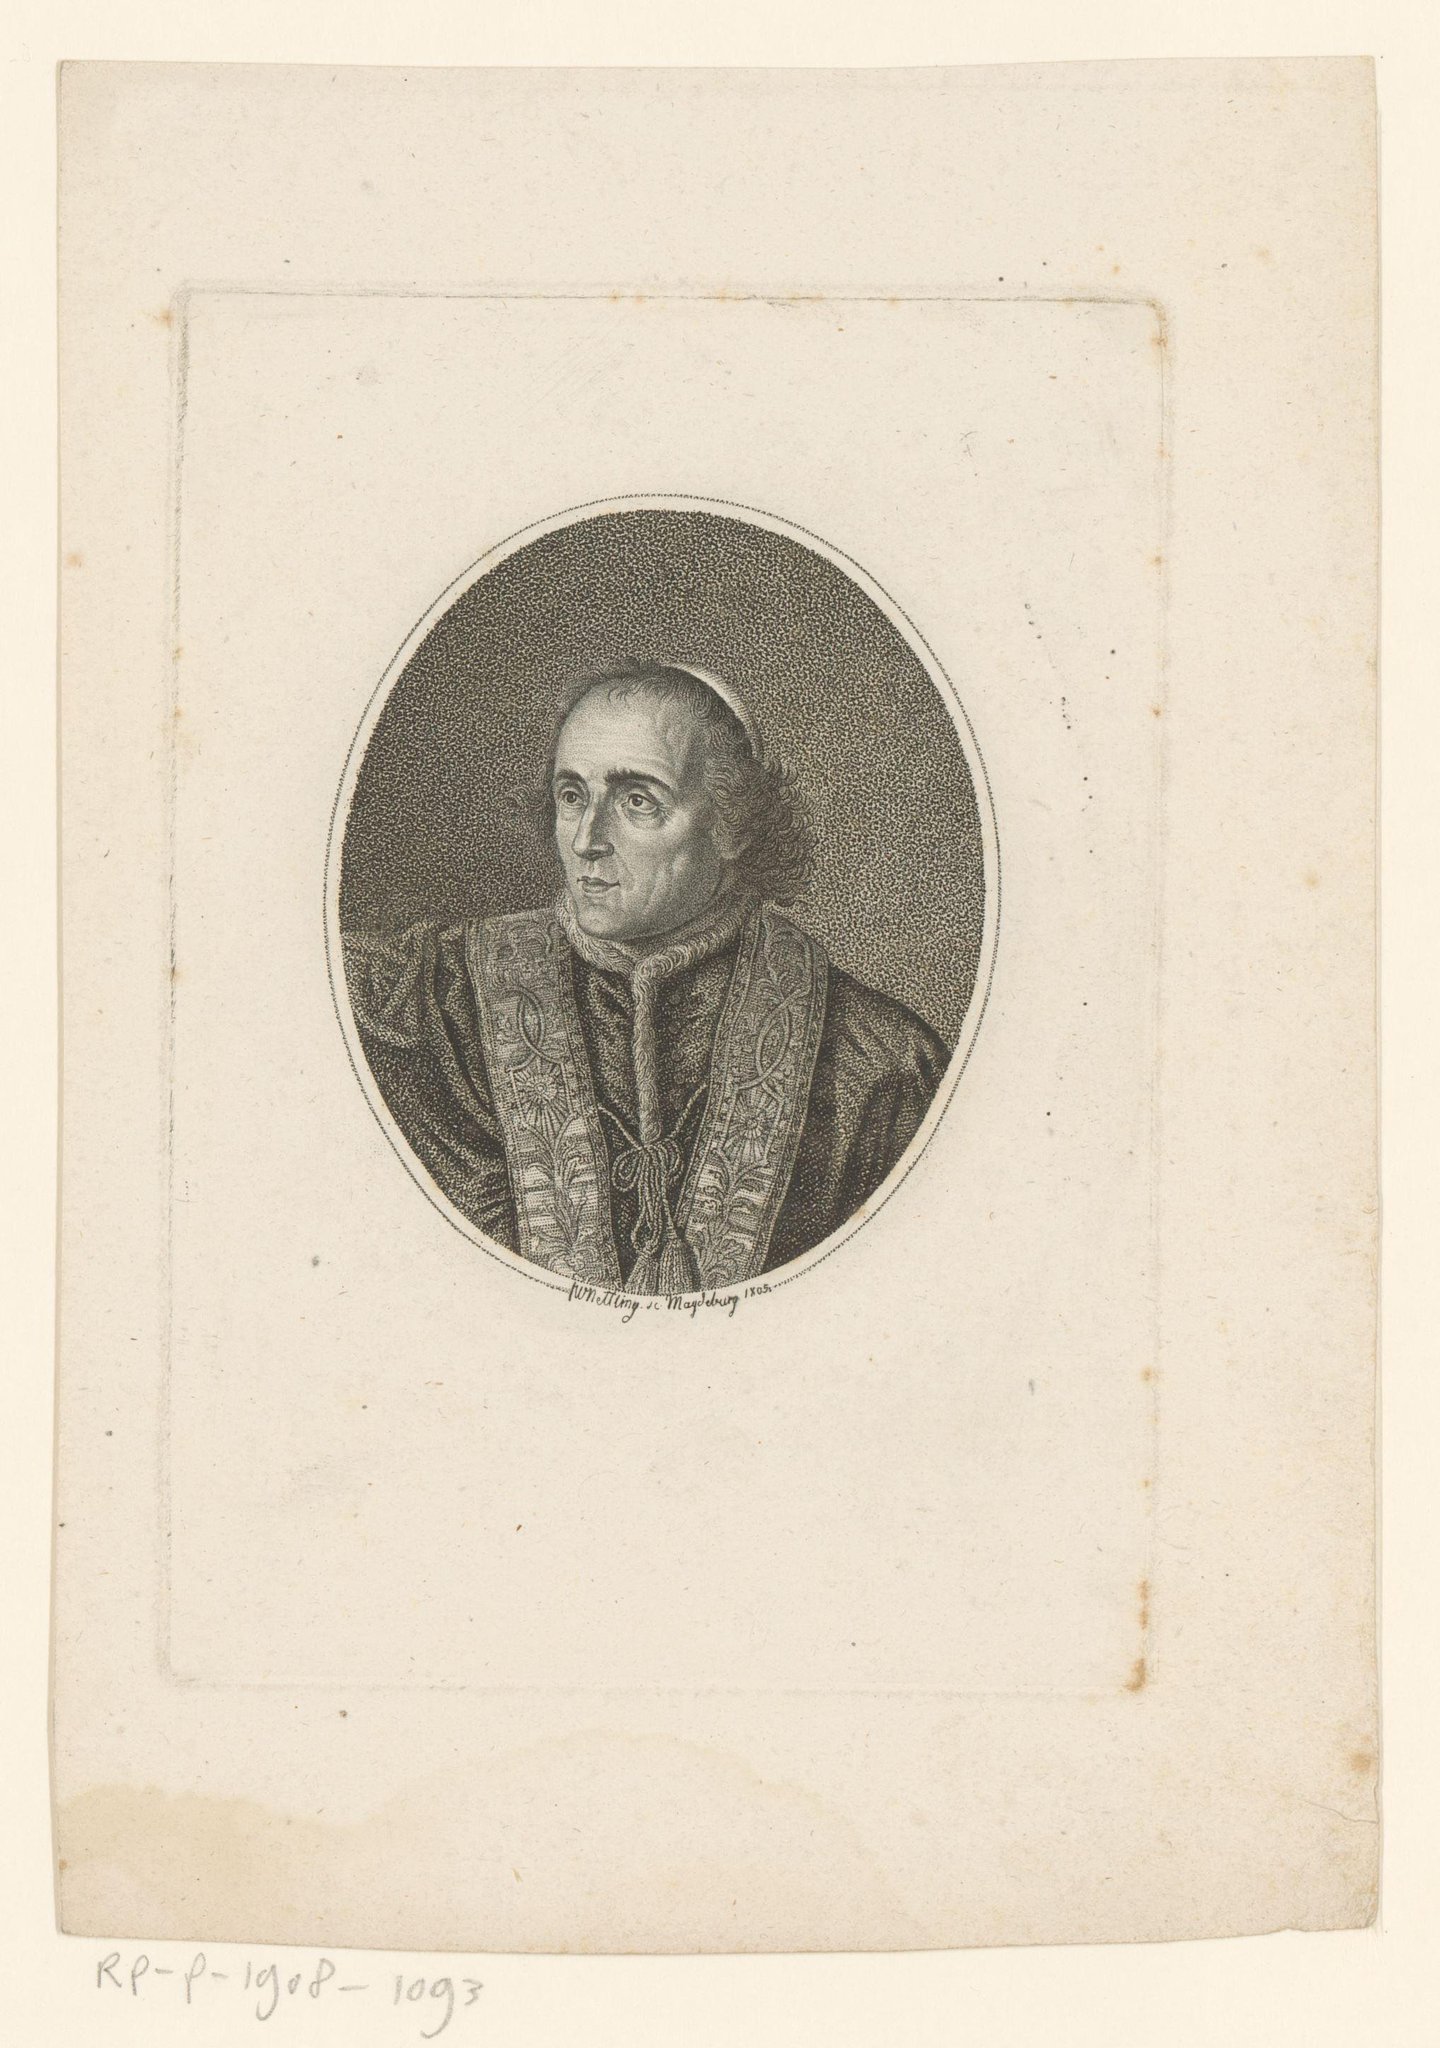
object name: print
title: Portret van Pius VII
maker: friedrich wilhelm nettling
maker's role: print maker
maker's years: 1793-1824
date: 1805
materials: paper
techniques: engraving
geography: magdeburg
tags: rome, clergyman, pius vii, liturgical vestments, canonicals, historical persons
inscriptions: collector's mark: Lugt 2228